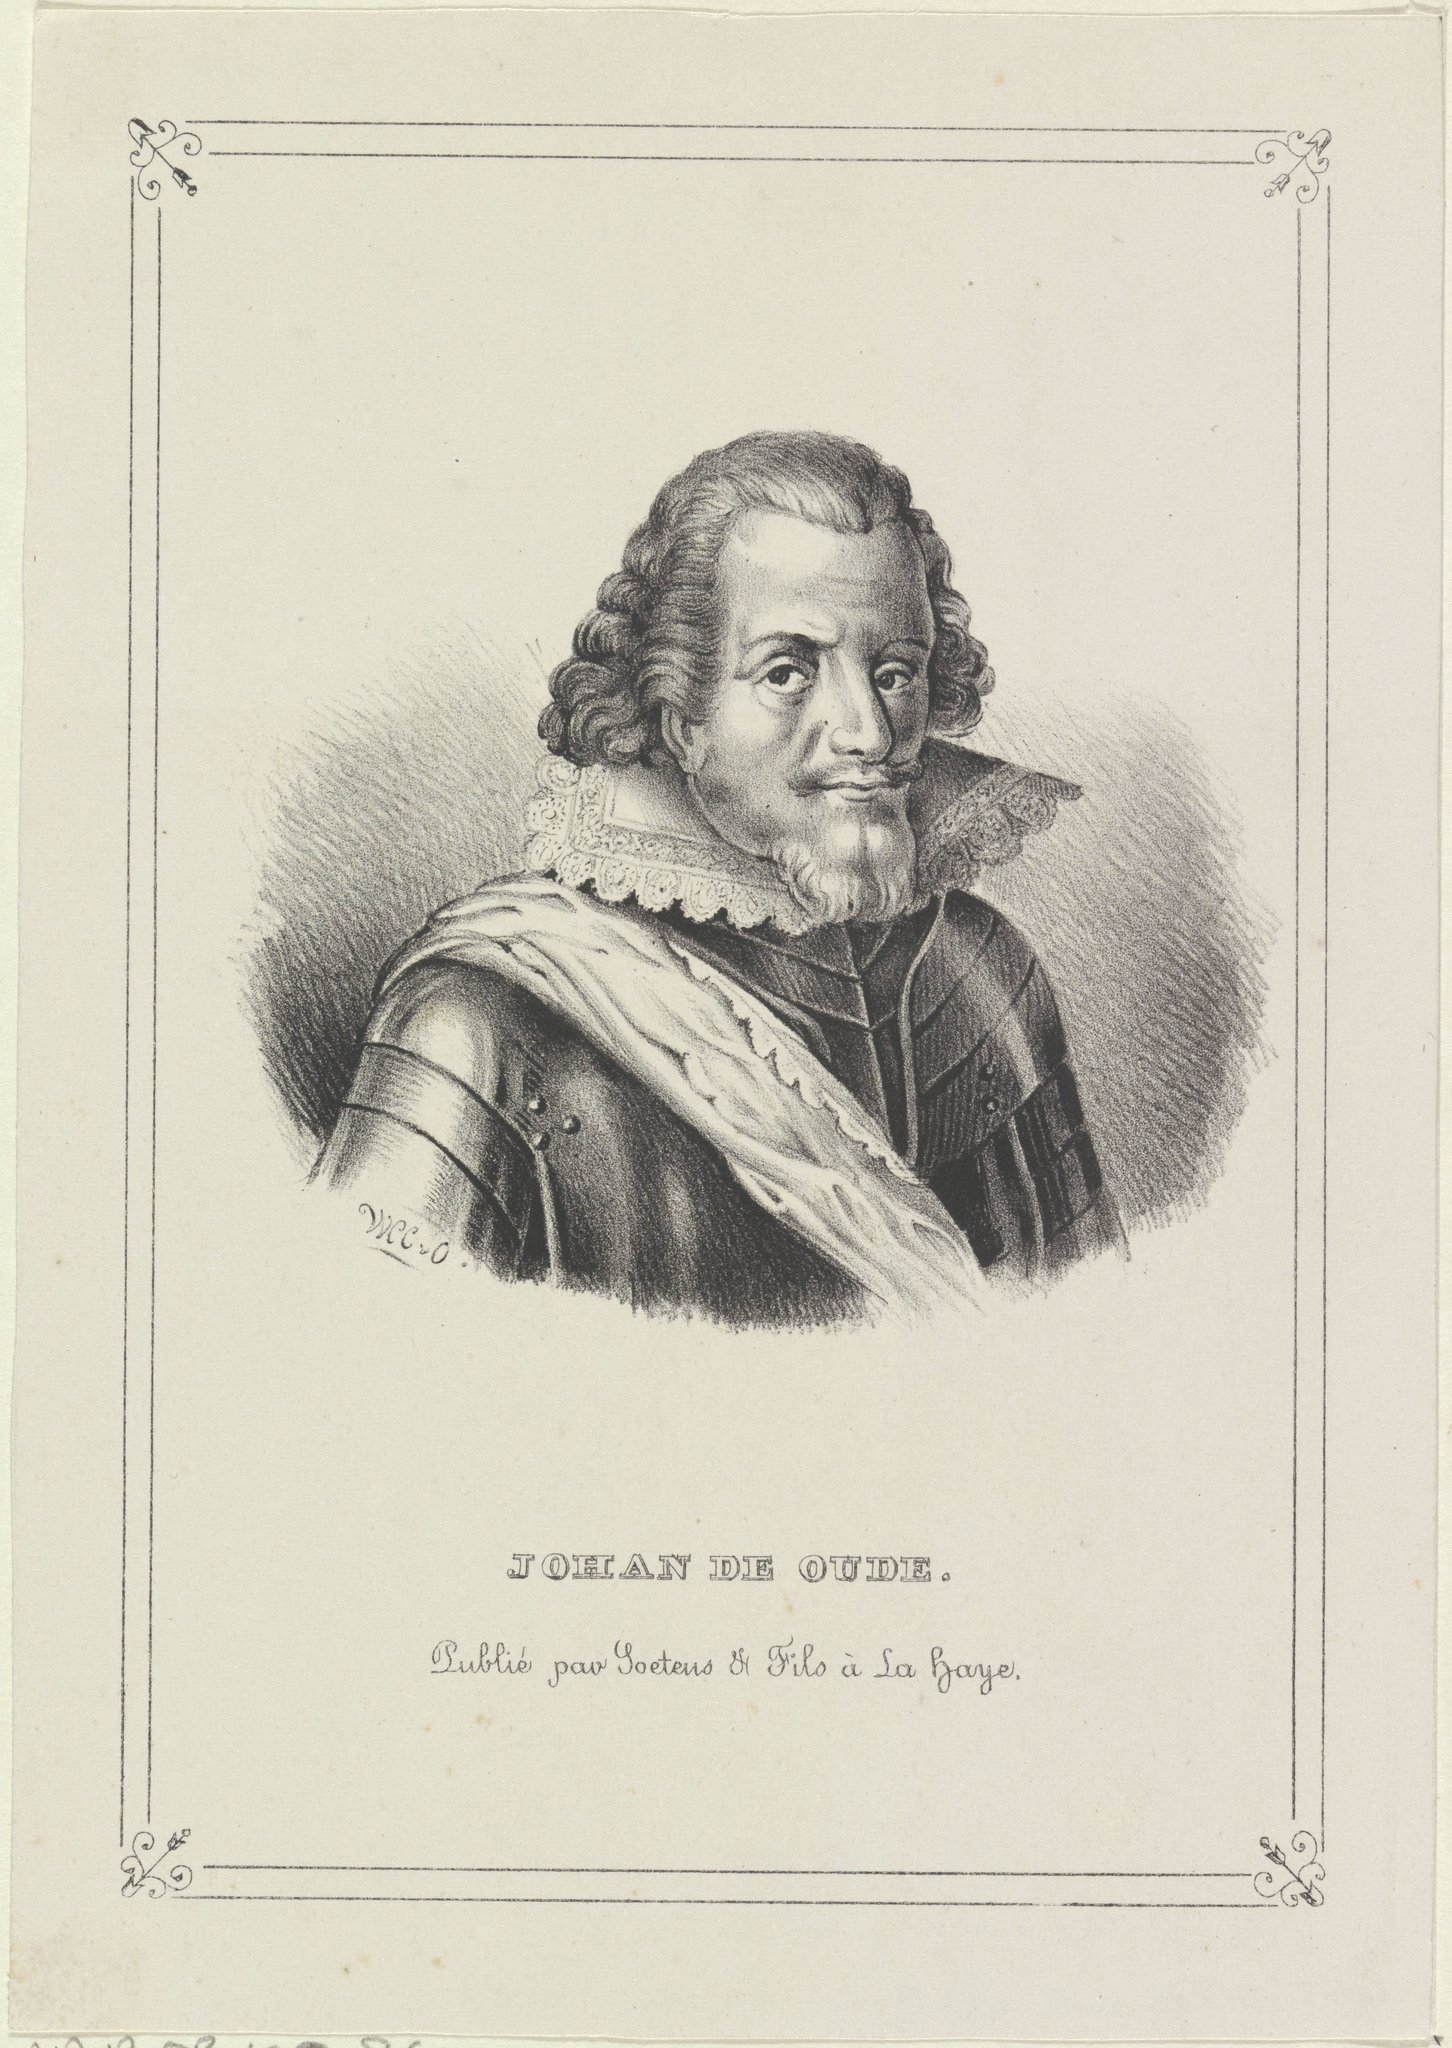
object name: print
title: Portret van Johan VII, graaf van Nassau-Siegen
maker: wilhelmus cornelis chimaer van oudendorp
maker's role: print maker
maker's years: 1822-1873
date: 1837-1840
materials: paper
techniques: lithograph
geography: the hague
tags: dillenburg, siegen, johan vii graaf van nassau-siegen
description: De hier vermelde titel verwijst naar de hoogst verkregen titel van de geportretteerde, niet per se naar de titel die de geportretteerde op deze voorstelling draagt.